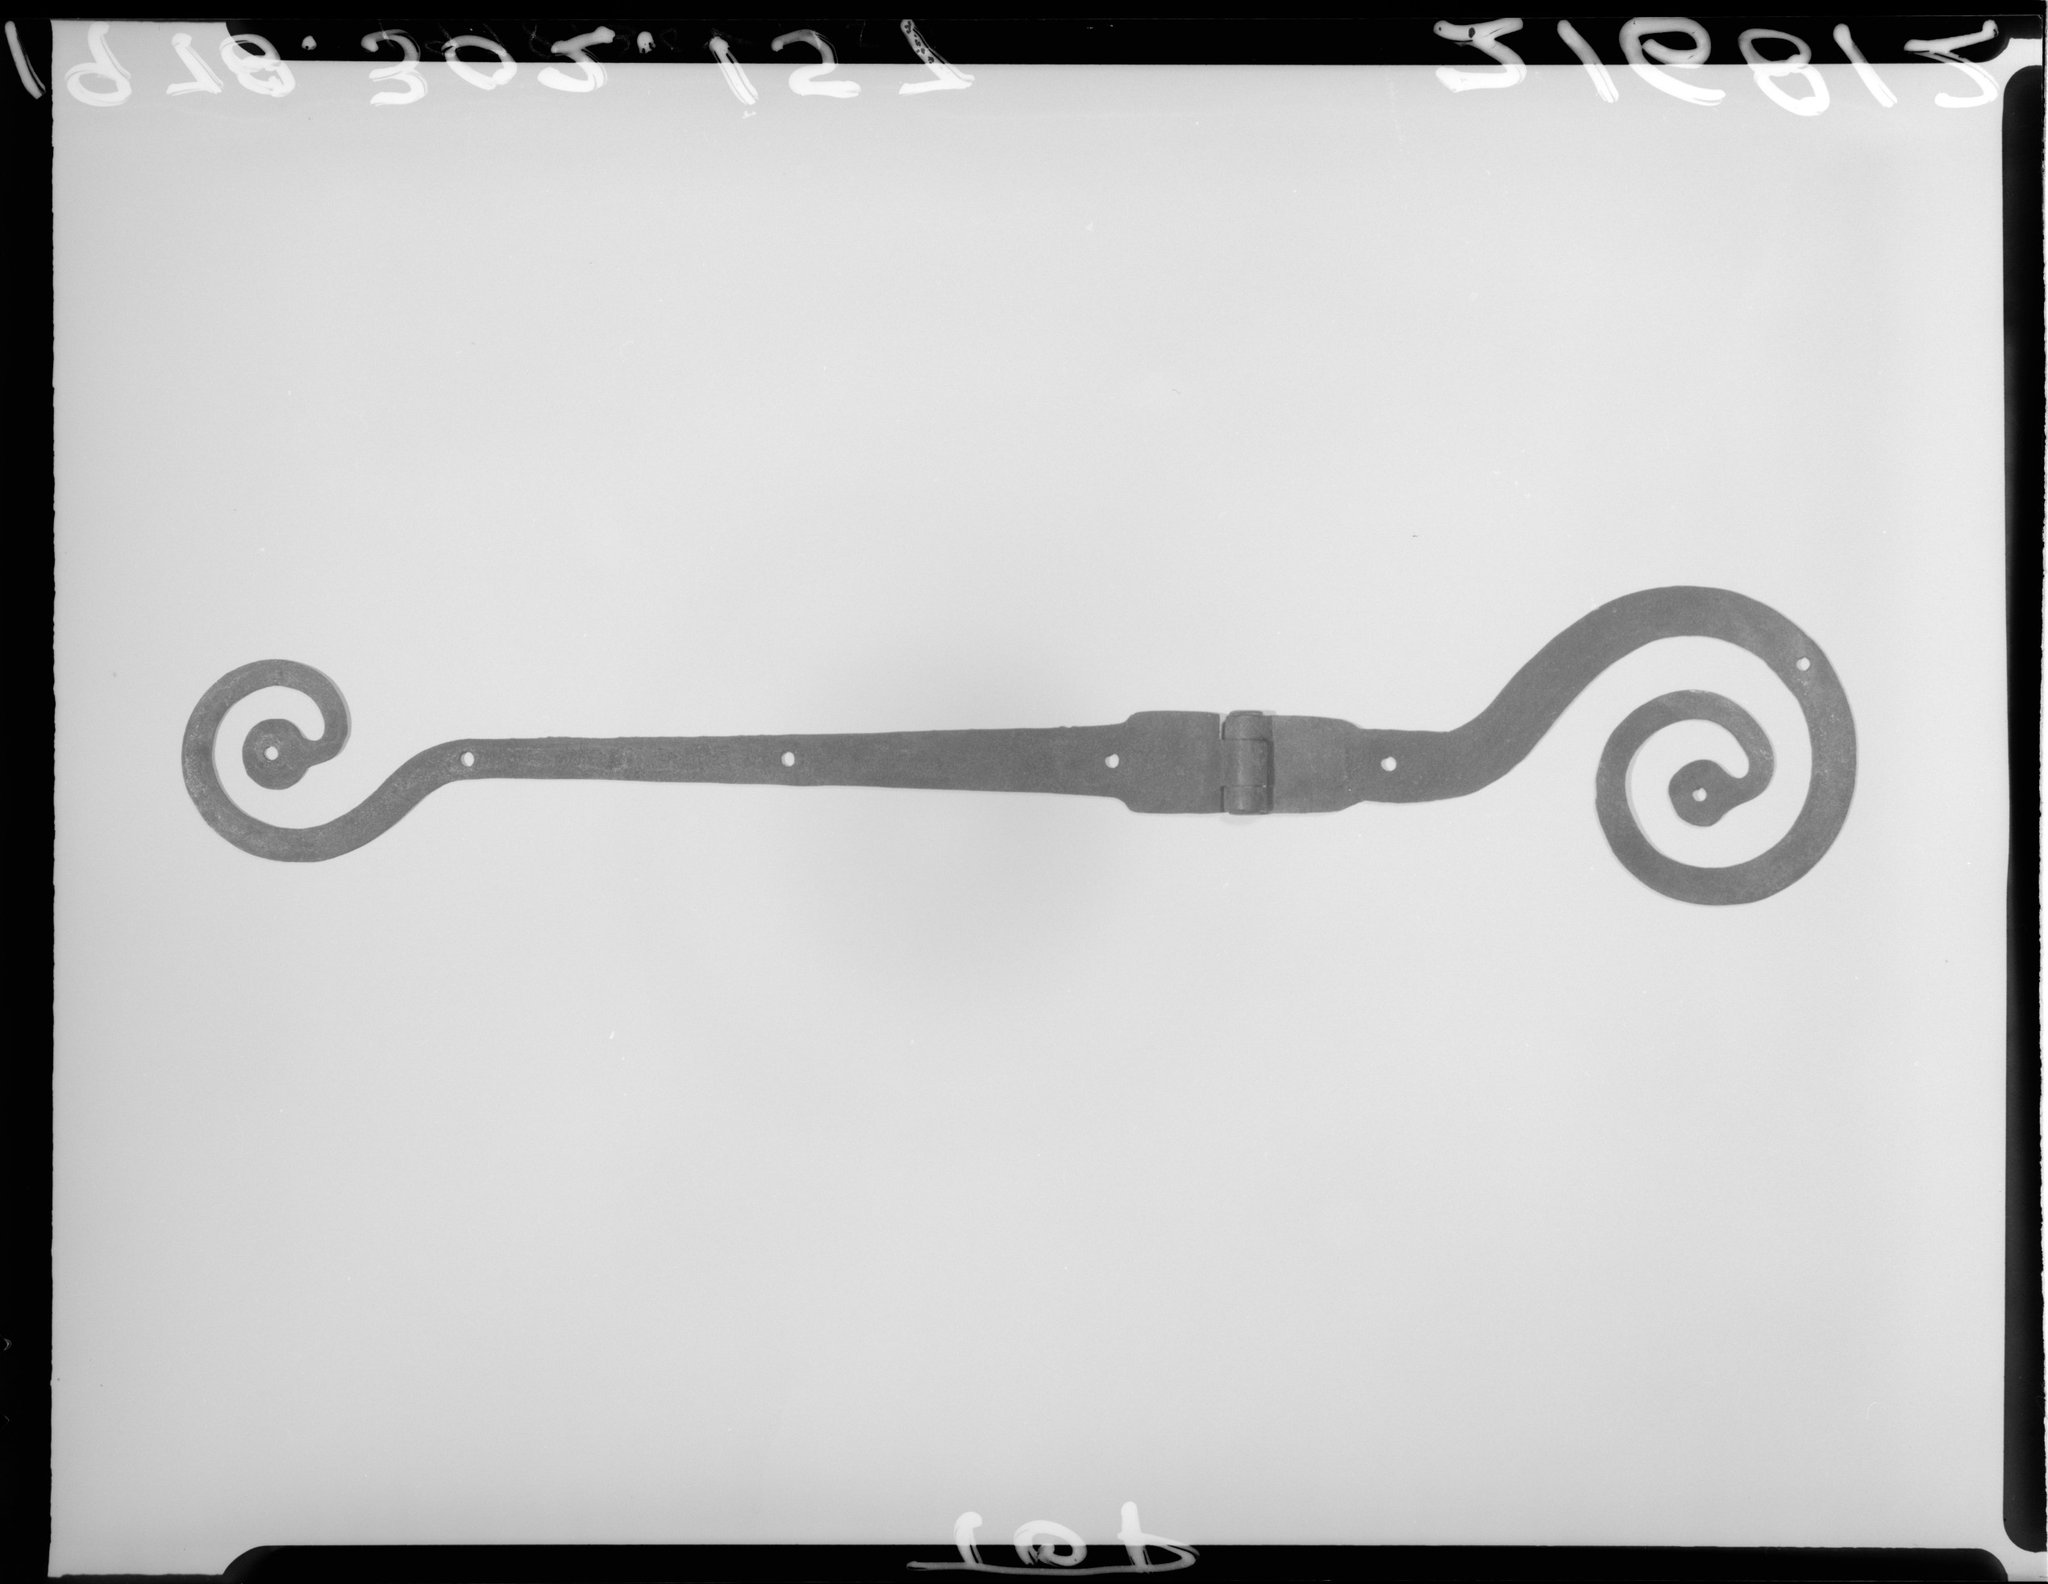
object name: door hinge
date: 1700-1800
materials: iron